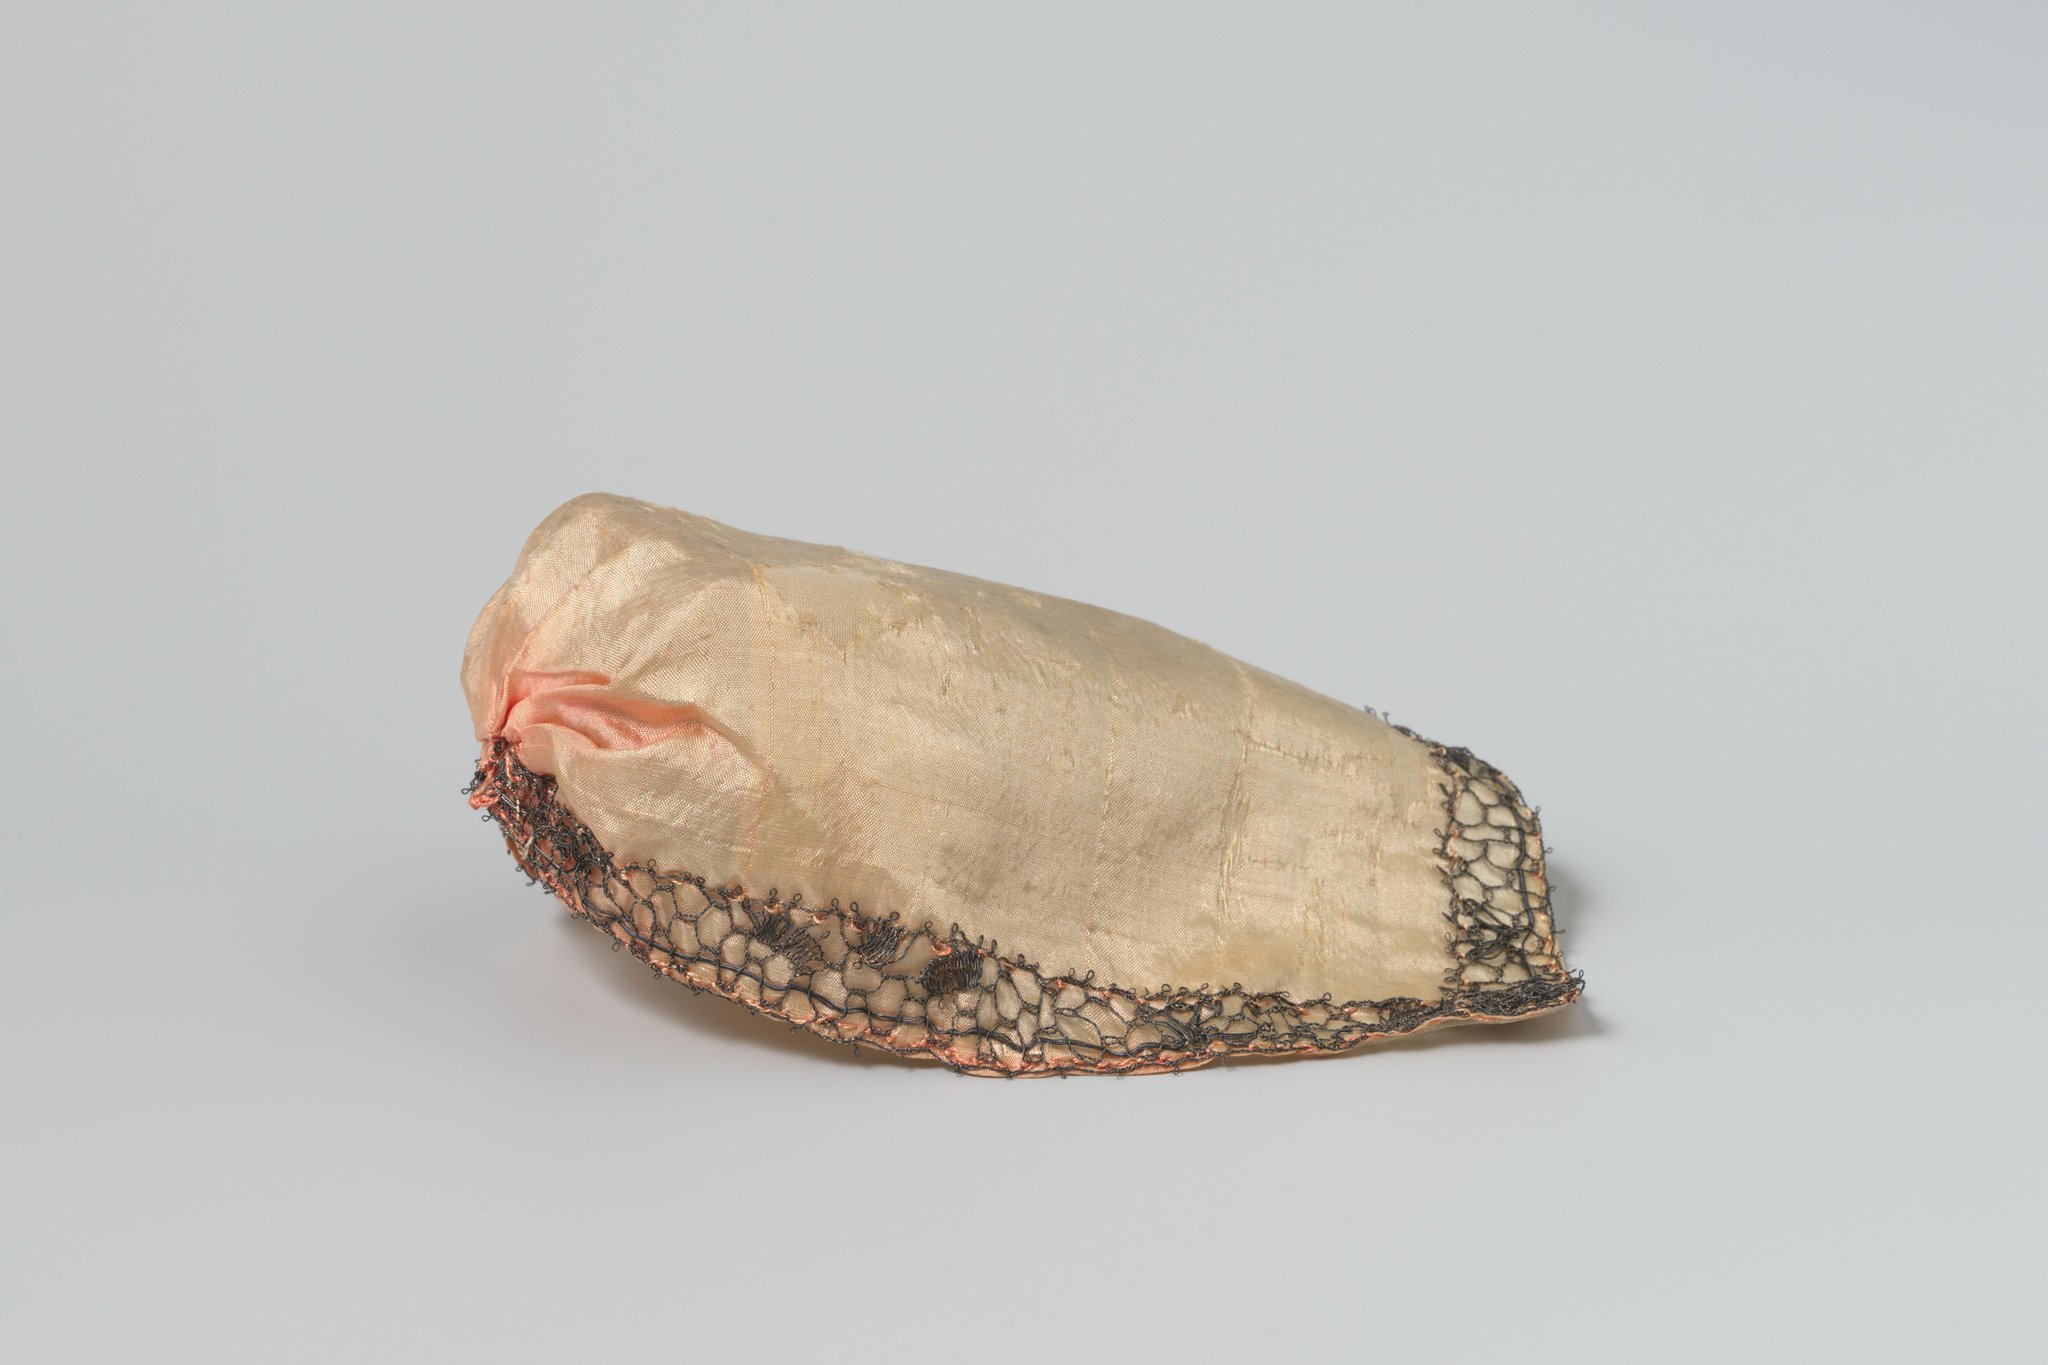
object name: miniature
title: Wiegenkleed, vervaardigd van zachtroze zijde, afgezet met goudkant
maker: Anonymous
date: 1676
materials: gold thread, silk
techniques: gold lace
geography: amsterdam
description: Wiegenkleed, vervaardigd van zachtroze zijde, afgezet met brede strook goudkant aan drie zijden. De achterzijde, zonder kant, is ingerimpeld en met trens verbonden.